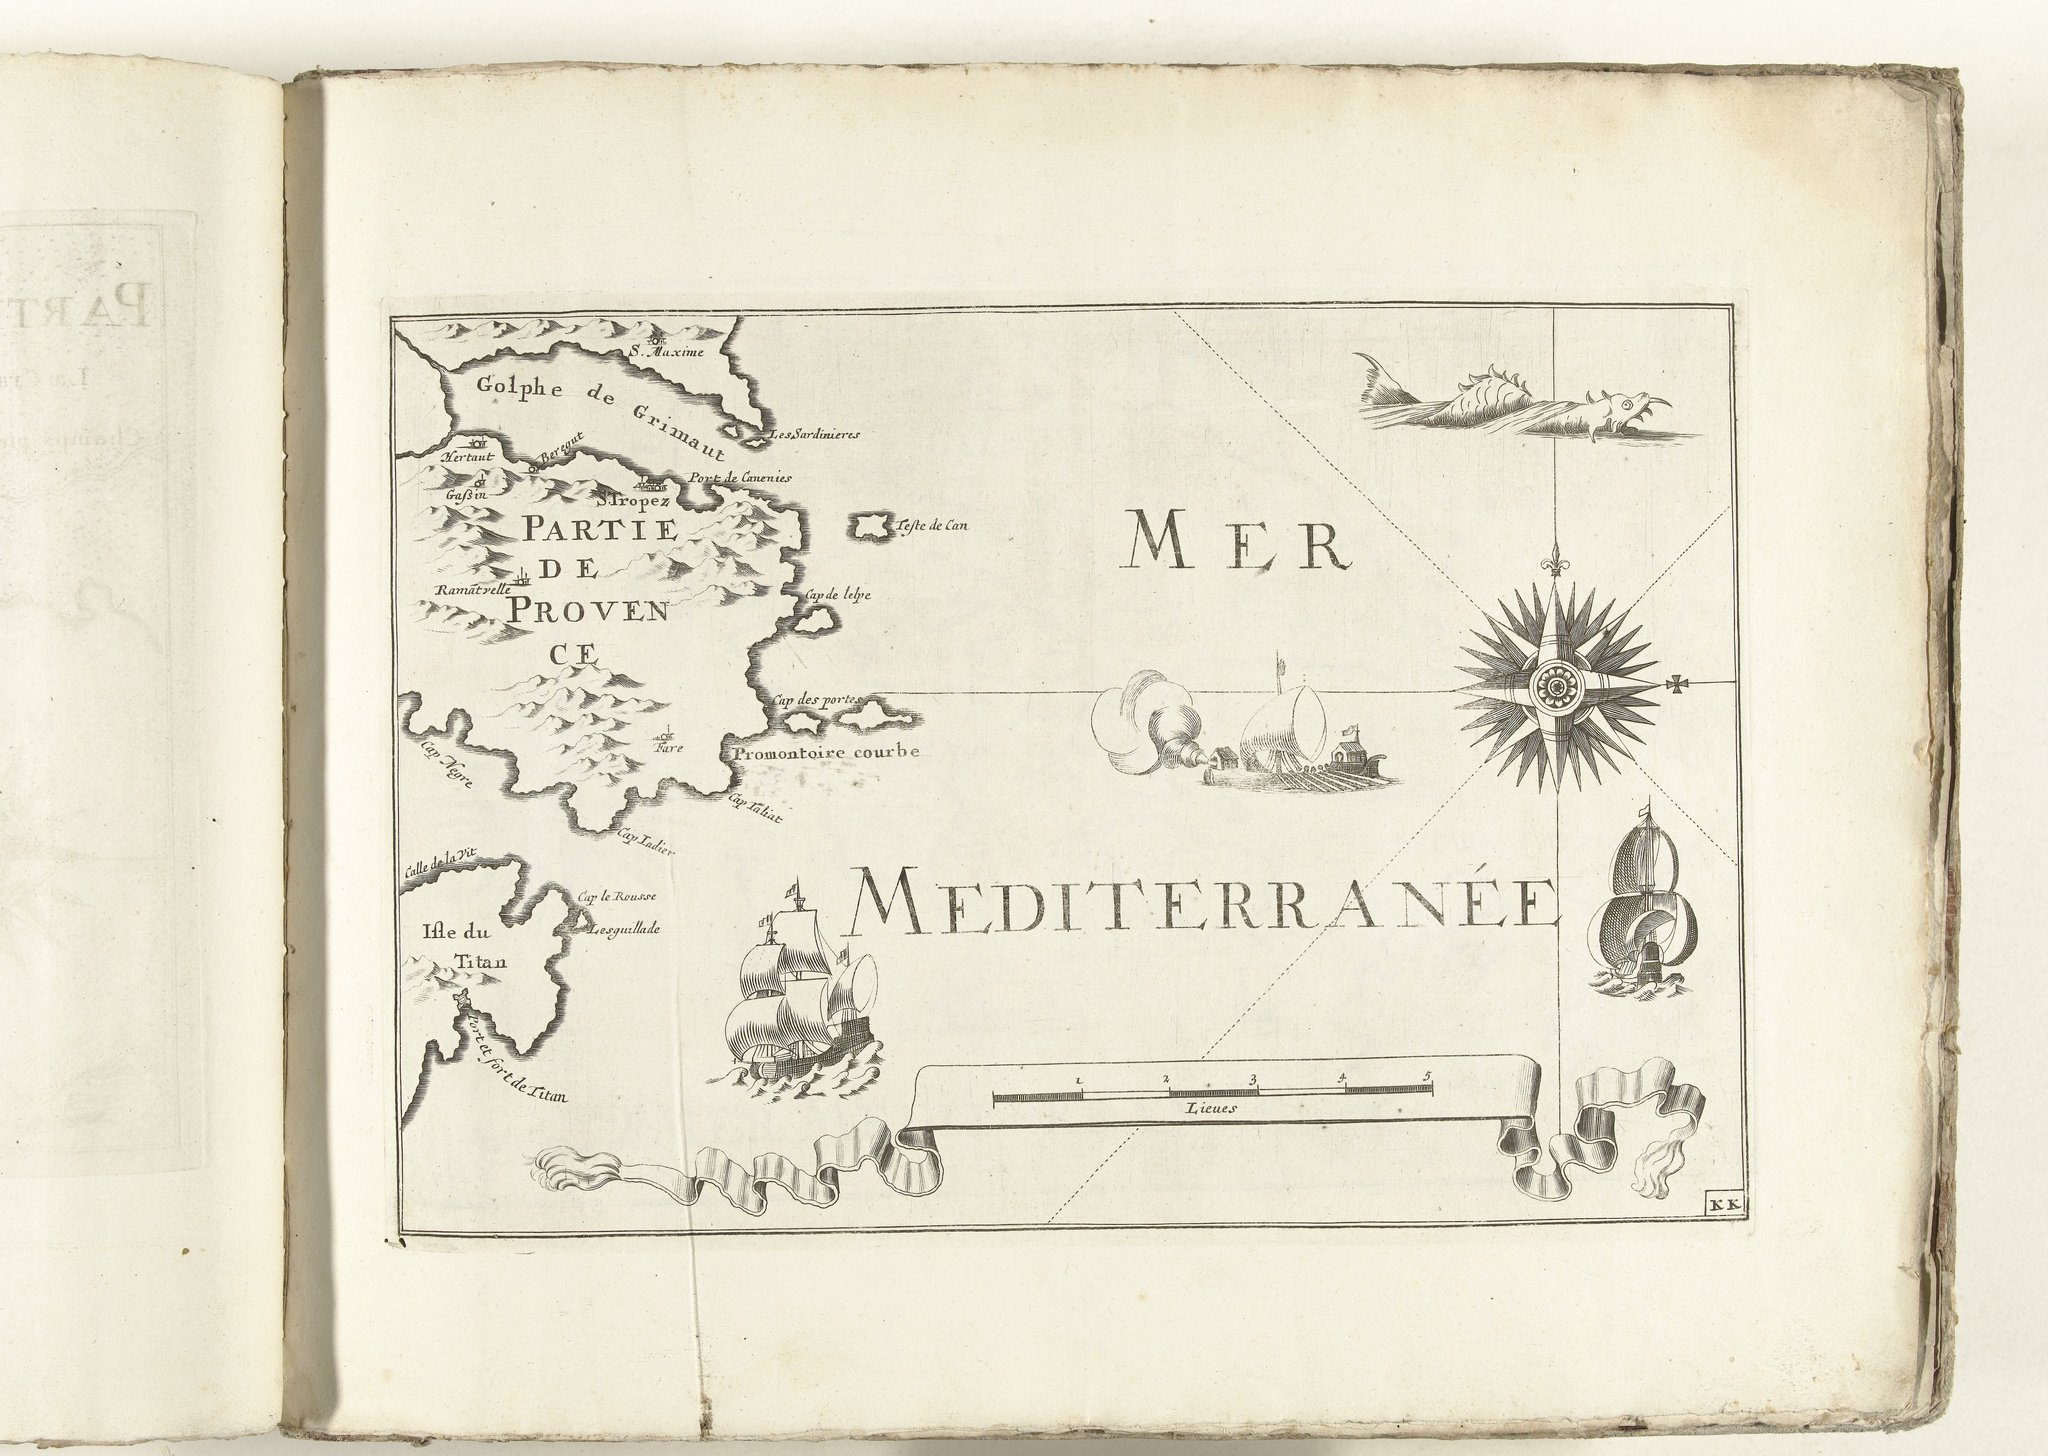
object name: map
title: Les Forces de l'Europe, Asie, Afrique et Amerique, ou description des principales villes avec leurs fortifications. Dessignées par les meilleurs ingenieurs, particulierement celles qui sont sous la domination de la France (...) et ornées de plusieurs superbes edifices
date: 1702-1703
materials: paper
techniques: engraving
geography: amsterdam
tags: maps of separate countries or regions, france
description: Kaart van de Franse zuidkust bij Saint-Tropez. Gemerkt rechtsonder: KK. Onderdeel van het tweede van twee delen van het prentwerk: Les costes de France et d'Espagne (oftewel deel 14 van: Les Forces de l'Europe, Asie, Afrique et Amerique), uitgegeven ca. 1702. Het prentwerk bestaat in totaal uit 43 gemerkte platen van de kust van Frankrijk en Spanje, in het kader van de Spaanse Successieoorlog. Deze platen zijn gekopieerd naar anonieme Franse platen oorspronkelijk uitgegeven door Nicolas de Fer te Parijs. Titel en opschriften in de plaat in het Frans.